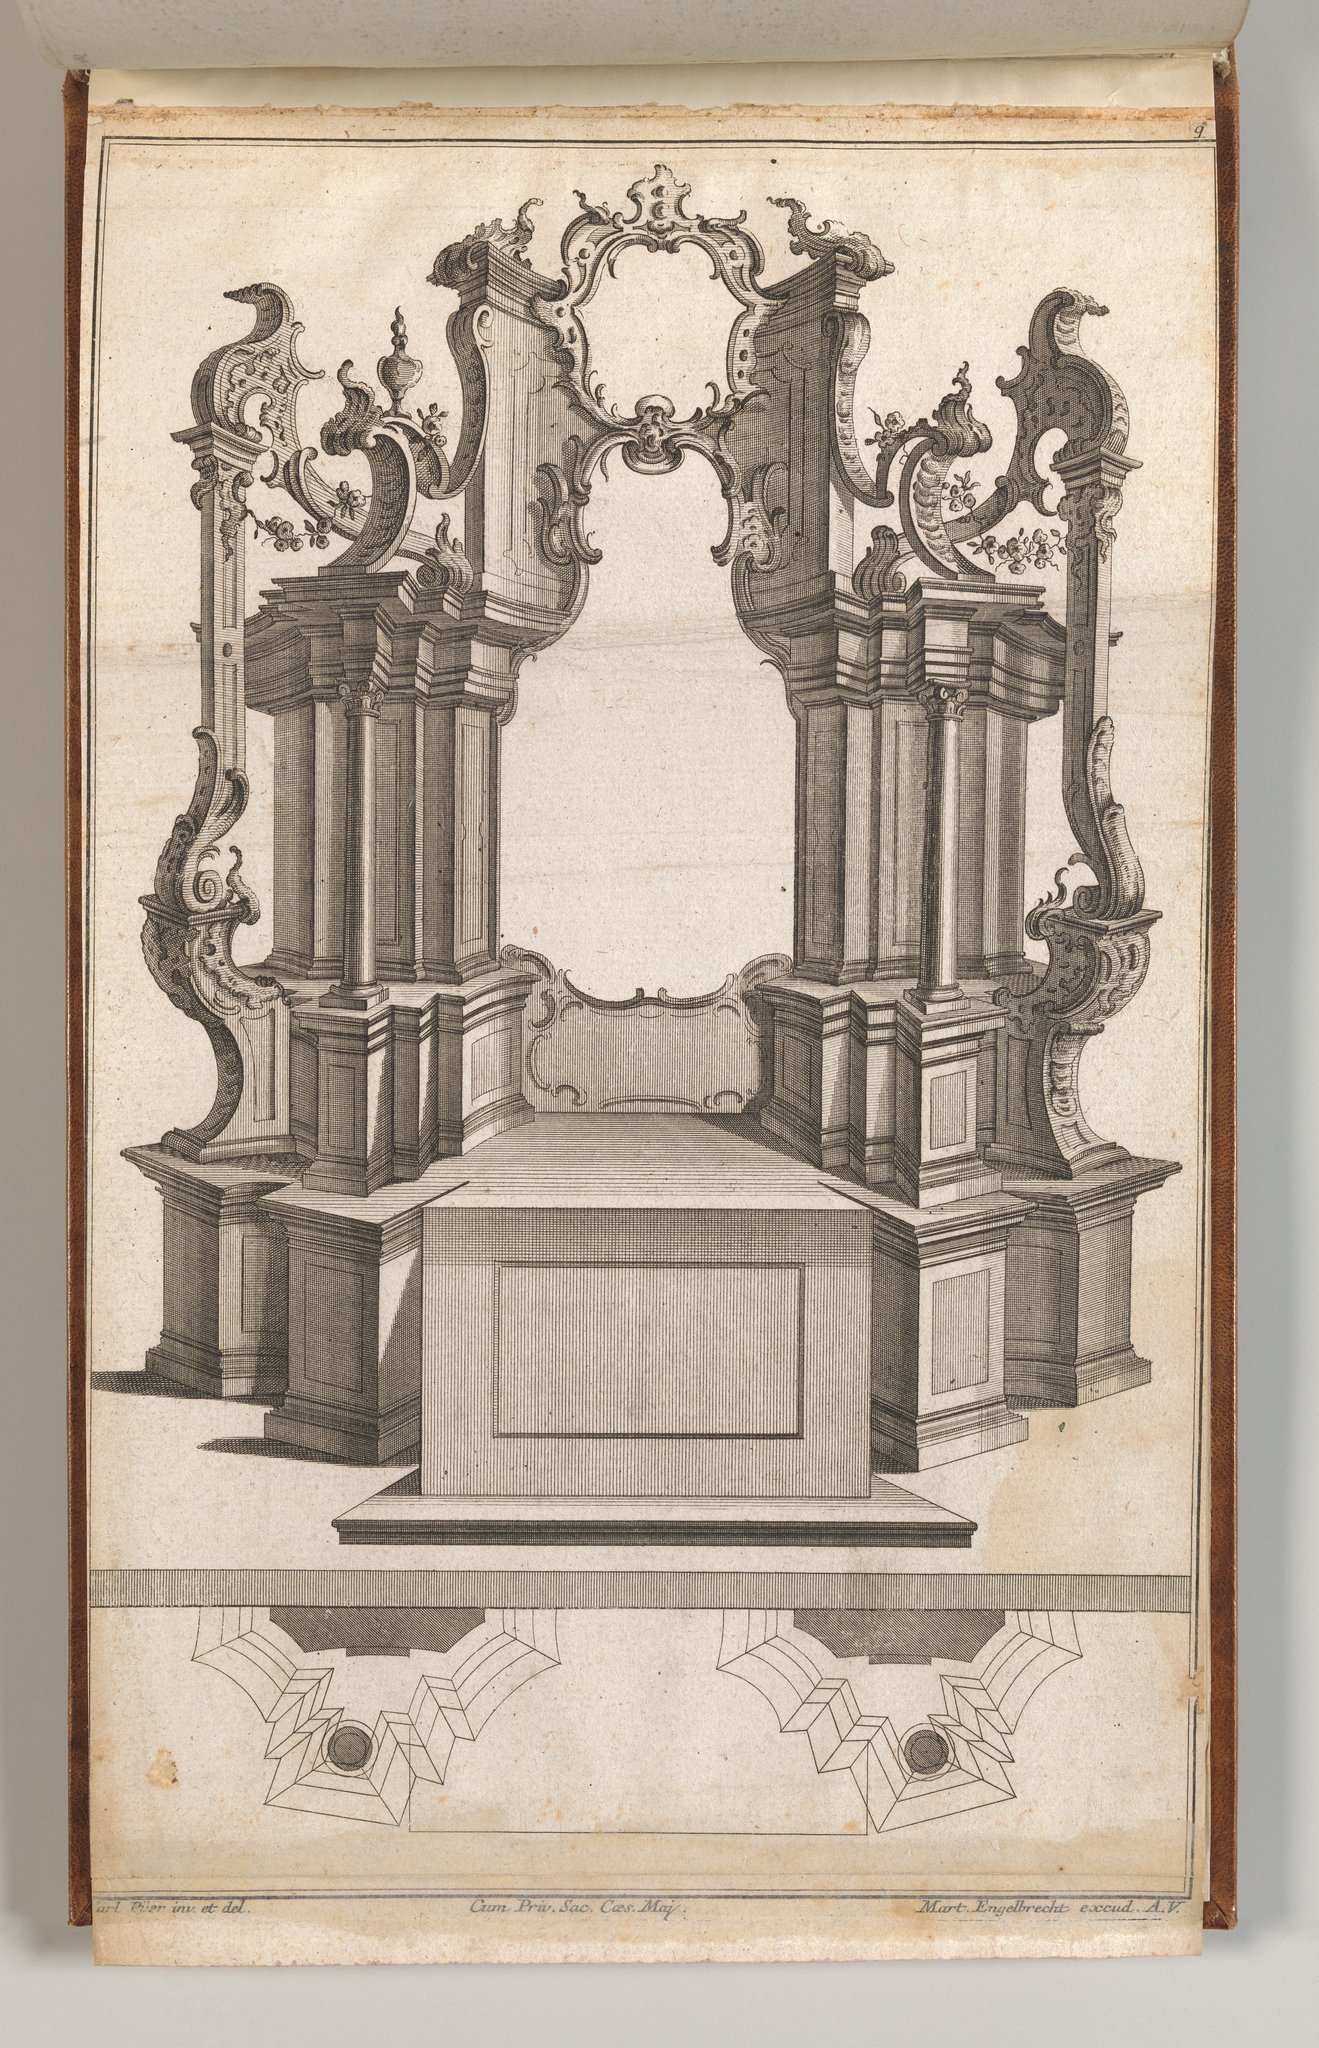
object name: album print ornament architecture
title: Design for a Monumental Altar, Plate 'q' from 'Unterschiedliche Neu Inventierte Altäre mit darzu gehörigen Profillen u. Grundrißen.'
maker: jacob gottlieb thelot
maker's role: engraver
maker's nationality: central european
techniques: etching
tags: altars